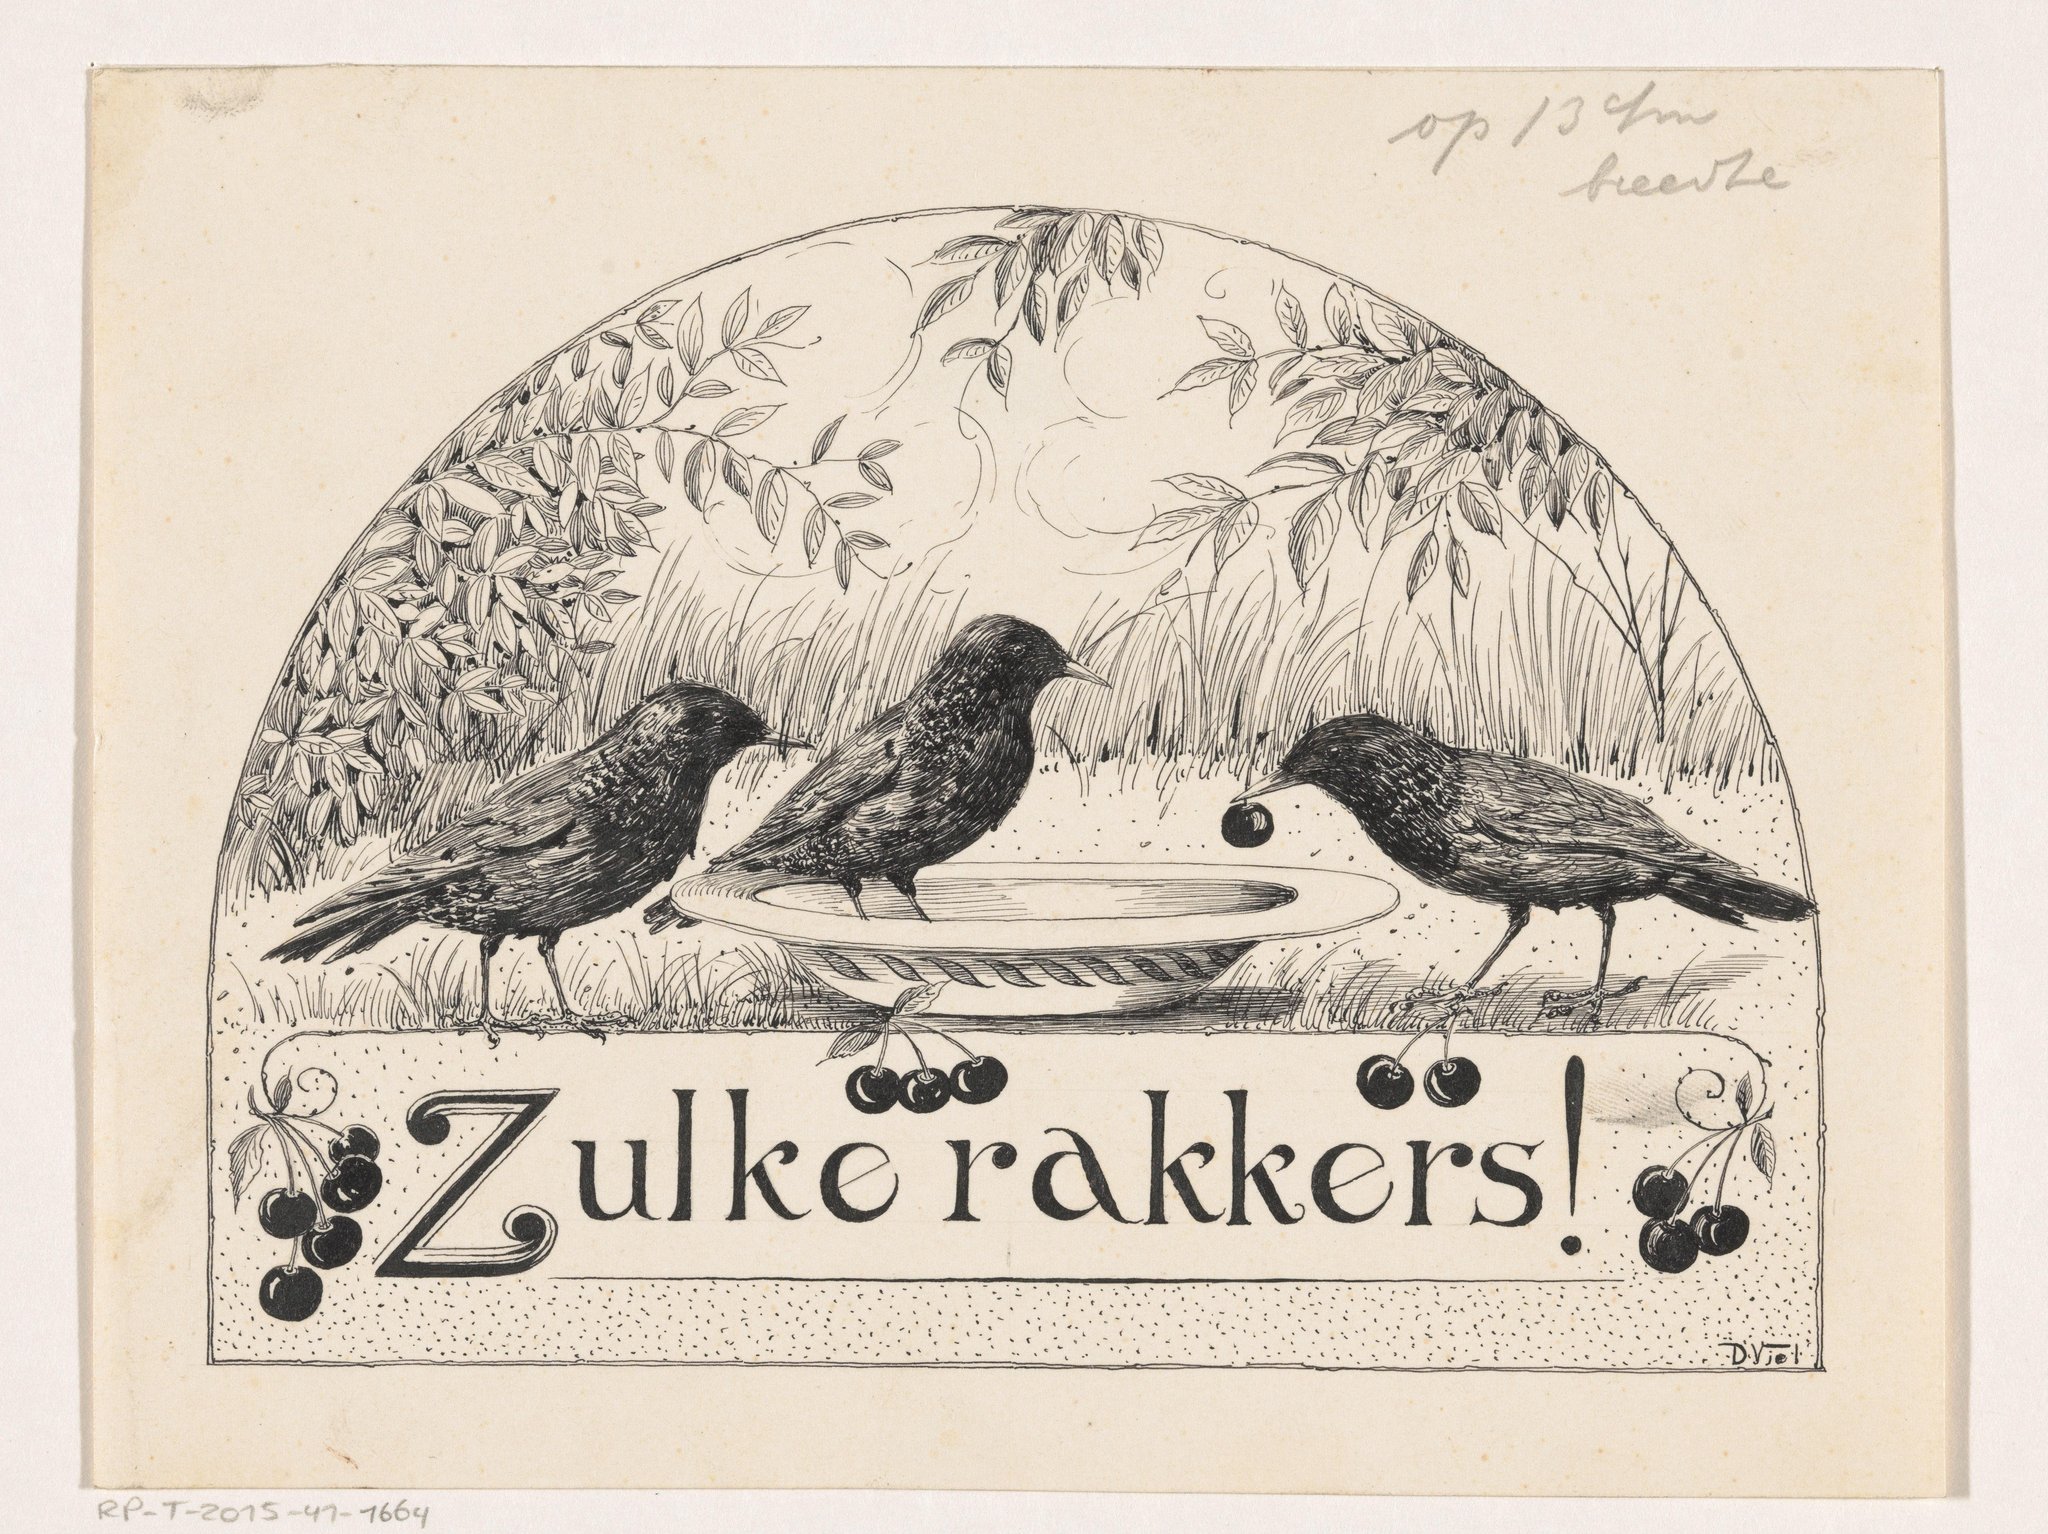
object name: boekillustratie ontwerp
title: Vogels eten kersen van een schaal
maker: d. viel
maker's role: draughtsman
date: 1915-1935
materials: paint, ink, paper, pencil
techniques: brush, pen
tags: birds, fruits: cherry, dish, plate, saucer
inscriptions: collector's mark: Lugt 2228, signature: ‘D Viel’, :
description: Drie vogels zitten naast en in een schaal. Eén van de vogels heeft een kers in de bek. Onder de voorstelling de hoofdstuktitel versierd met kersen.